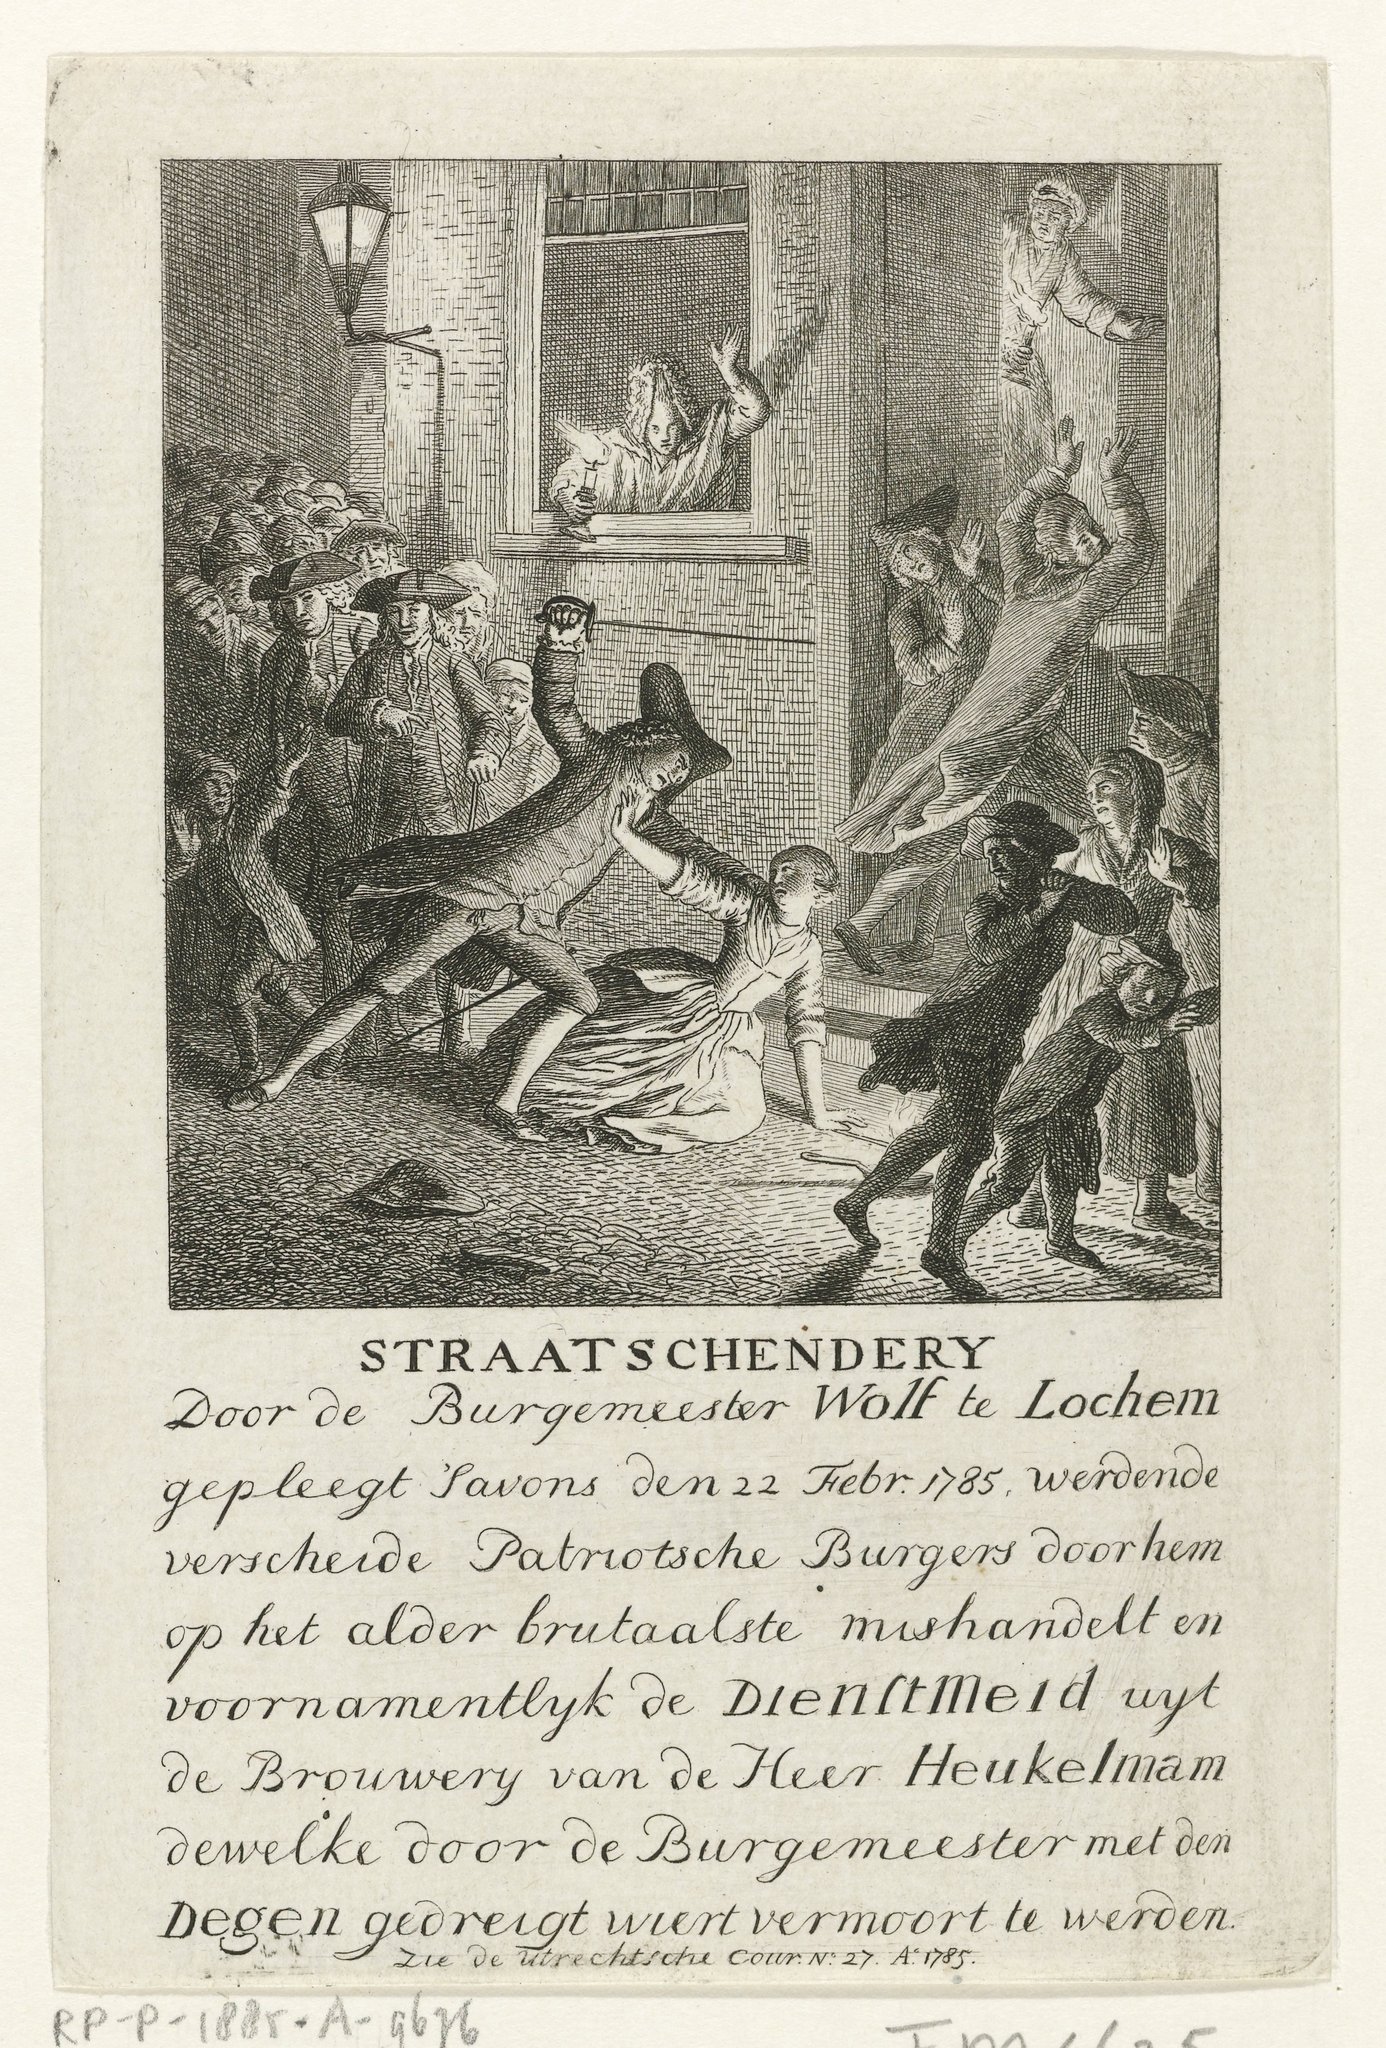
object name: print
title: Burgemeester Wolf van Lochem valt patriotse burgers aan, 1785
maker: joannes hulstkamp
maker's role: print maker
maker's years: 1759-1786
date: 1785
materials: paper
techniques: engraving, etching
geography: northern netherlands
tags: street-fights, riots, patriots (1780-1795)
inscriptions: collector's mark: Lugt 2228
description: Patriotse burgers, met name de dienstmeid uit de brouwerij van de heer Heukelman, in Lochem worden door burgemeester Wolf van Lochem op de avond van 22 februari 1785 aangevallen en met een degen bedreigd. Met verwijzing naar de Utrechtse Courant No. 27, 1785.